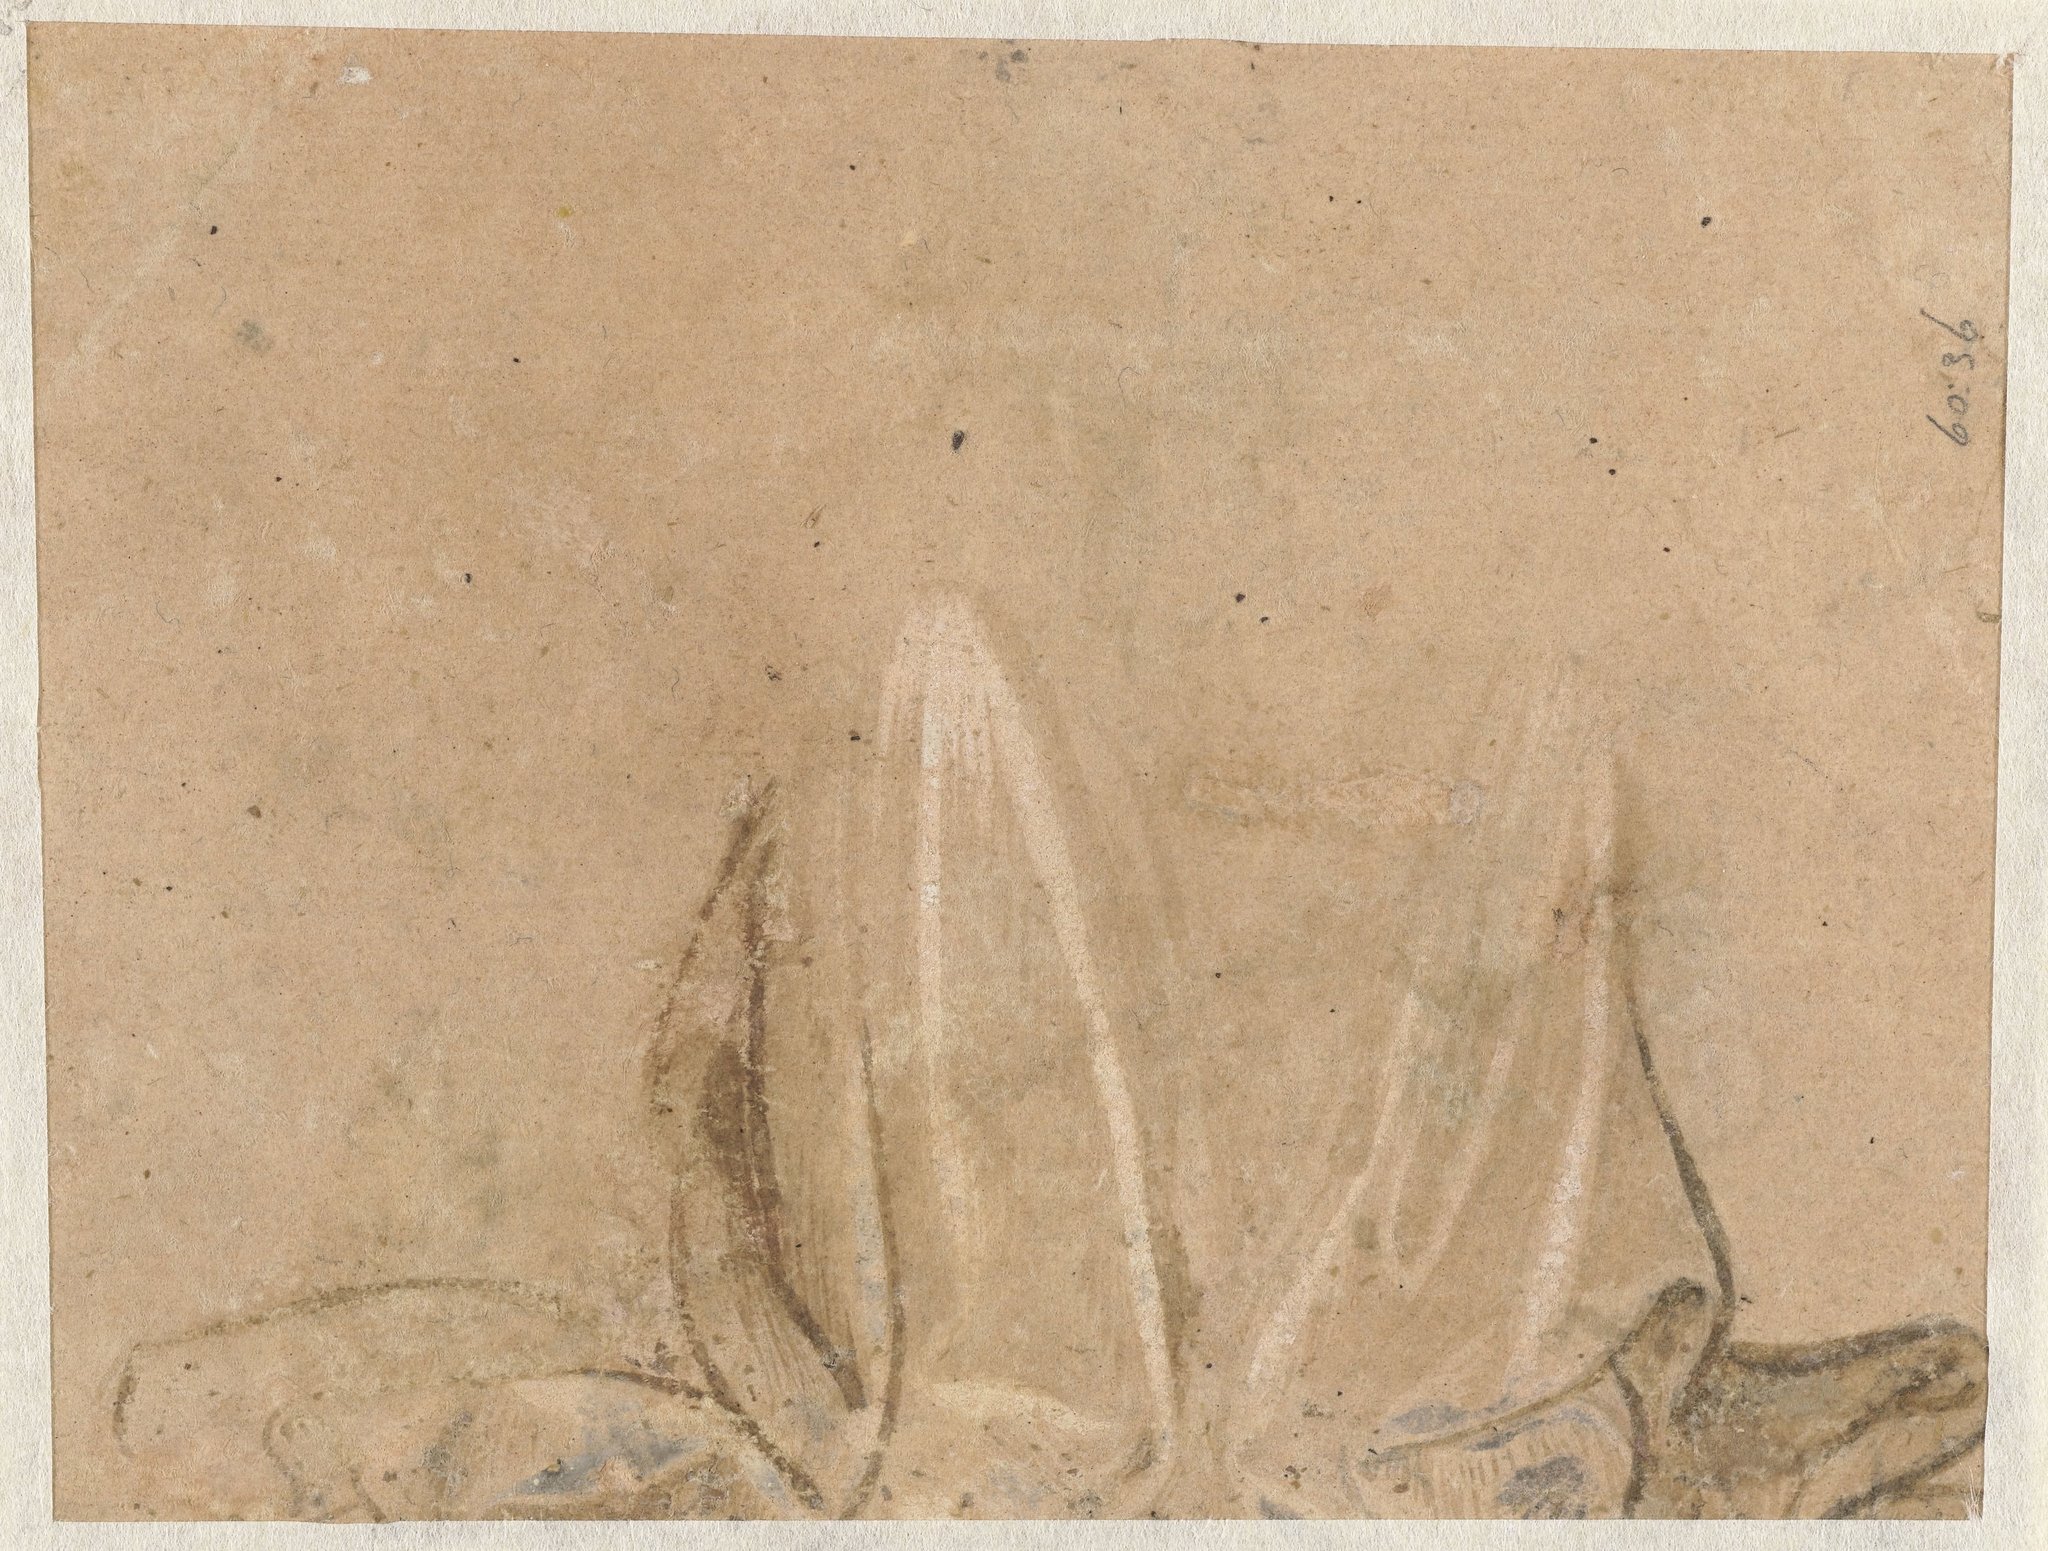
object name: drawing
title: Draperie-studie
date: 1450-1474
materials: ink, paper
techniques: pen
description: Blad uit een album met tekeningen van 15de-eeuwse kunstenaars uit Verona, Padua en Venetië.